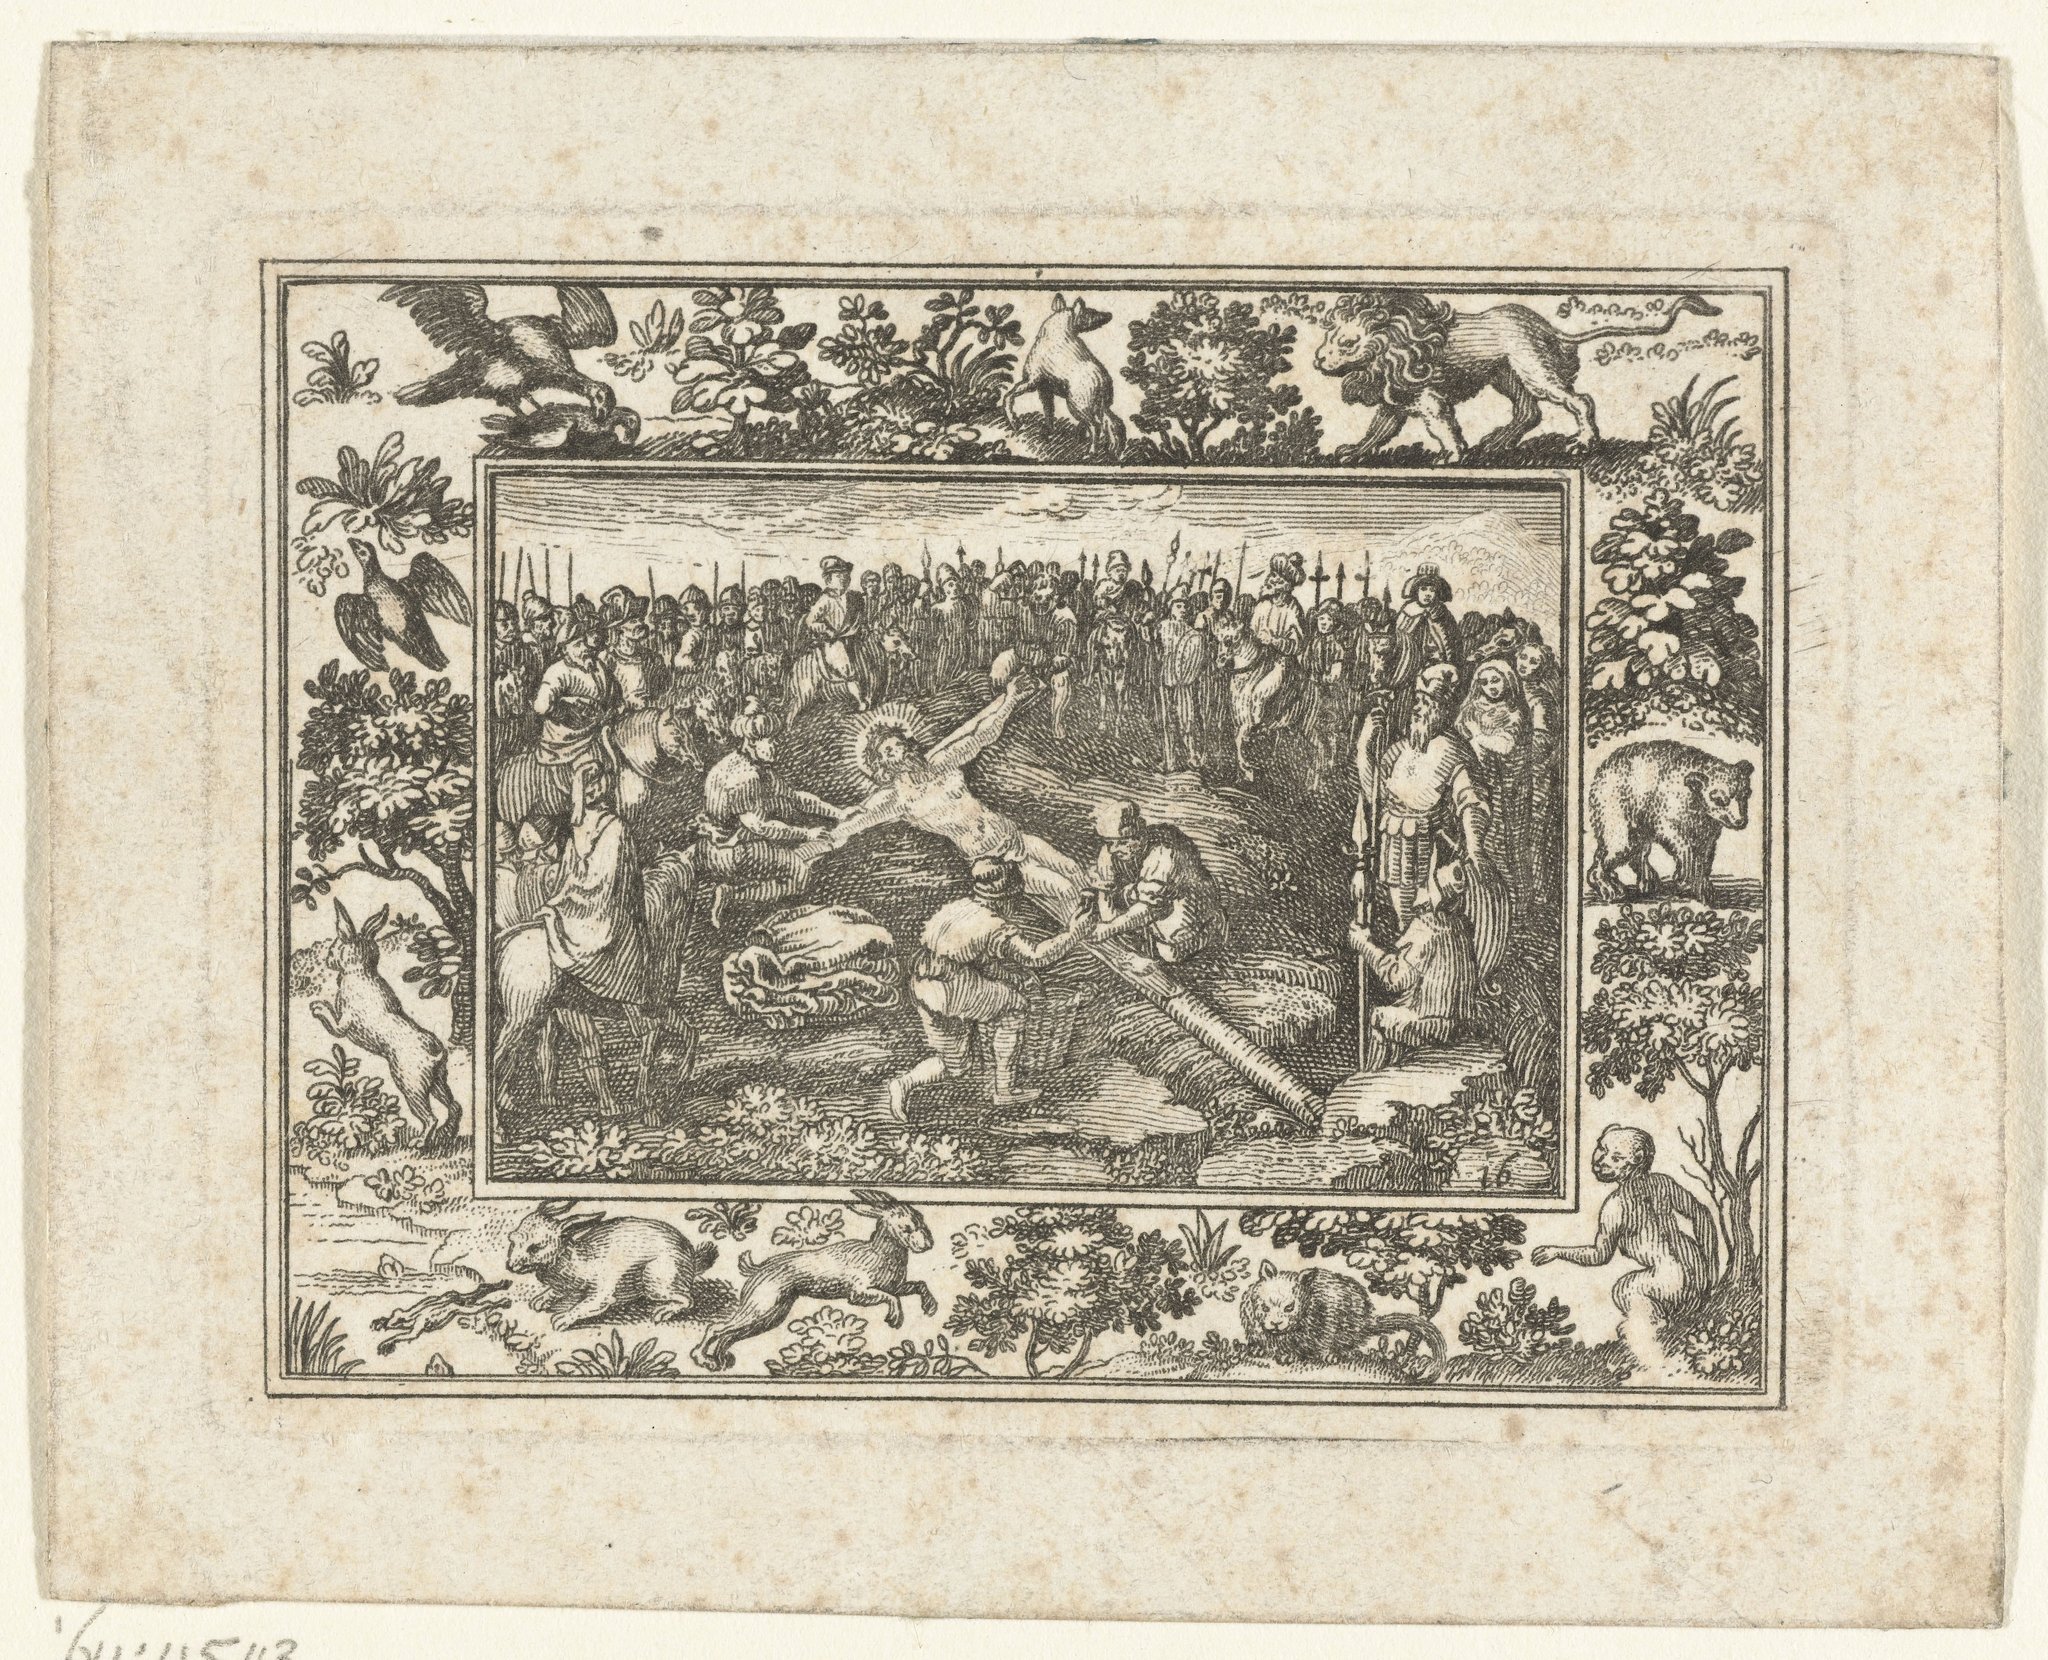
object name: print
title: Passievoorstellingen in lijsten met dieren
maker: Anonymous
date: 1600-1699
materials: paper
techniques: etching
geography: germany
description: Rechtsboven loopt een leeuw, linksonder springt een kikker in een vijver.